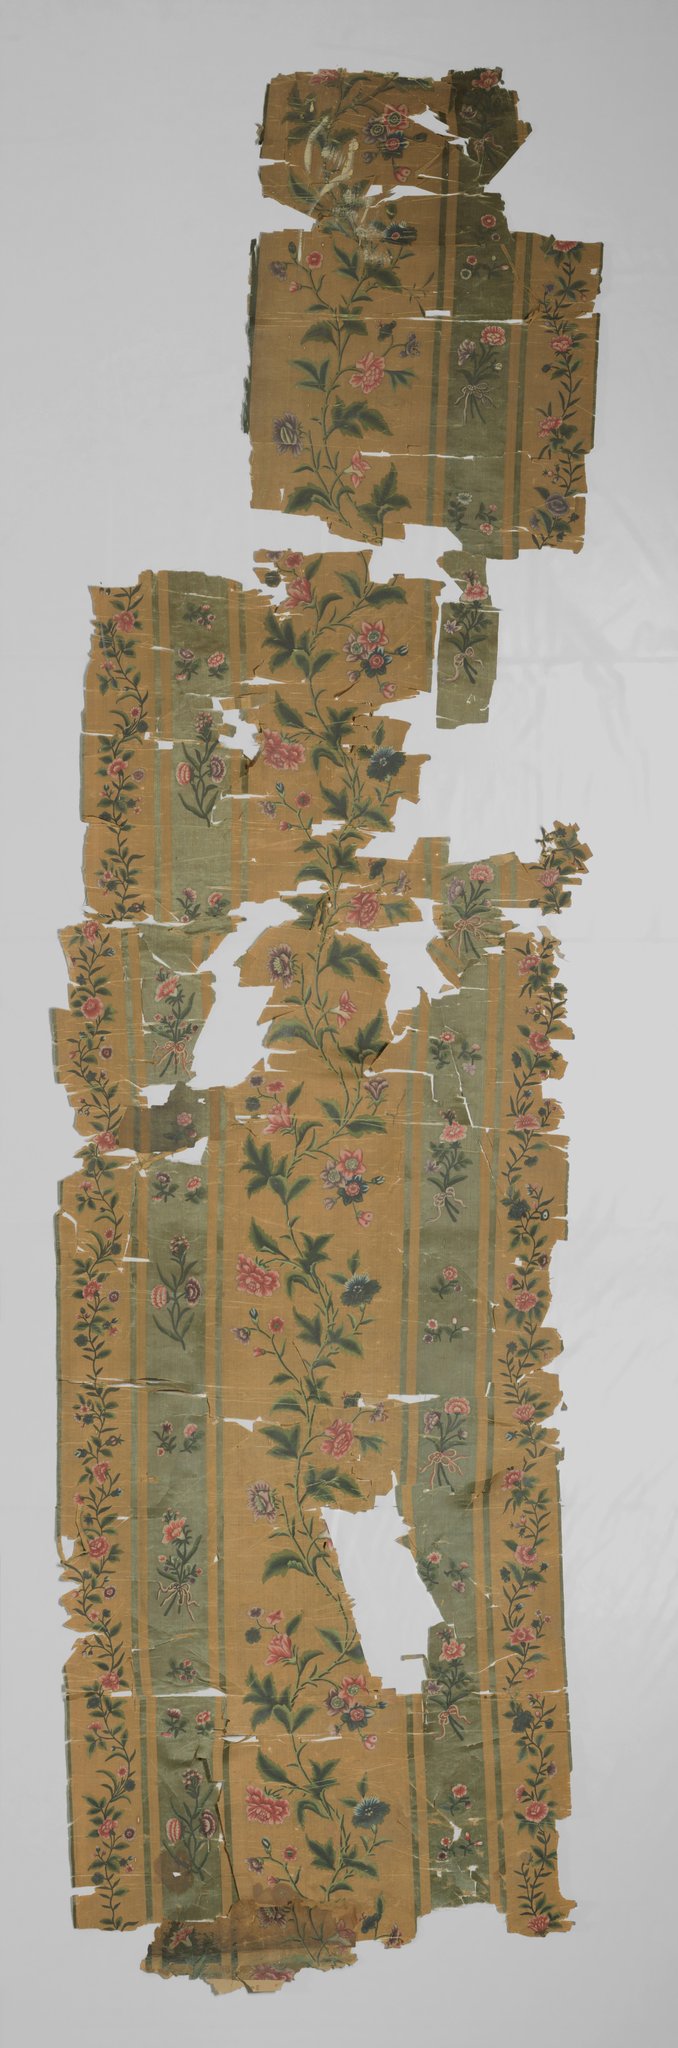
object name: interieuronderdeel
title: Behangsel, op zijde beschilderd met strepen, gestrikte boeketten, afgewisseld met losse bloemen en opstaande ranke met bladeren en bloemvariaties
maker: Anonymous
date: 1750-1800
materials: jute, paint, paper, silk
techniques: painted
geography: northern netherlands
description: Een wandvak met op zijde beschilderd behangsel. De crème-witte grond in ripsbinding, wordt per baan door twee grijsblauwe strepen in satijnbinding, verdeeld in een breed middenvak en smallere zijvakken. Op het blauw zijn gestrikte boeketten afgewisseld met losse bloemen geschilderd, op het middenvak een opstaande rank met bladeren en bloemvariaties in roze, lila en blauw en op de zijkanten een smallere rank met bloemen. In latere tijd is het behangsel op papier en op jute gezet.